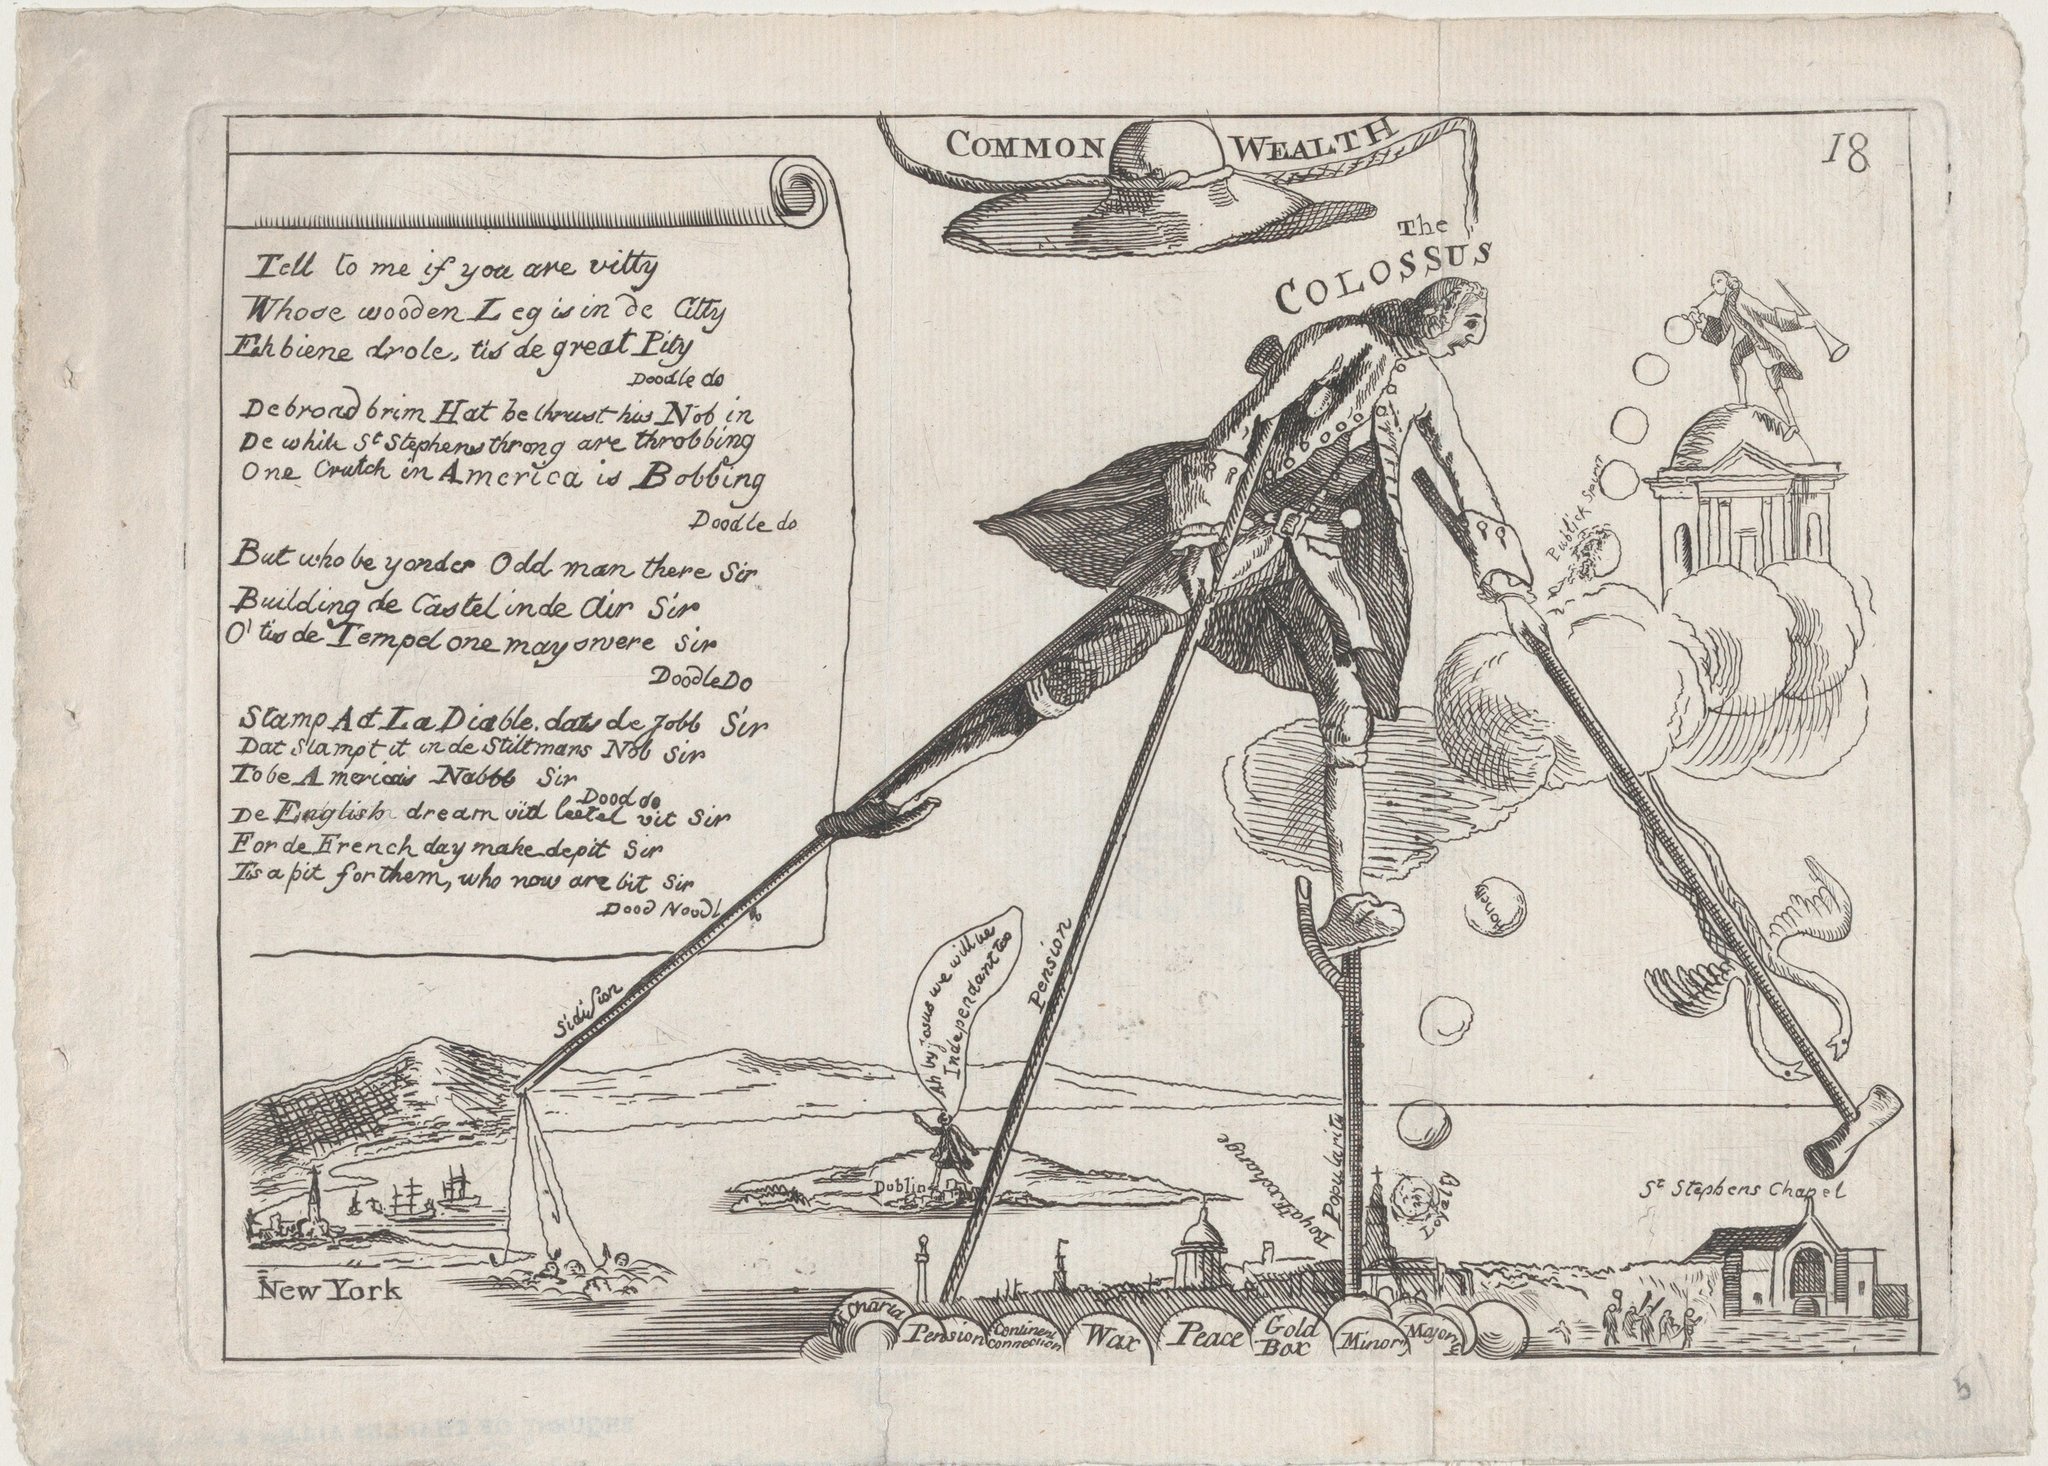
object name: print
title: Common-Wealth, The Colossus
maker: anonymous, british, 18th century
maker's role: artist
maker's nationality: british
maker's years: 1700-1800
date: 1766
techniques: etching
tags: satire,american revolution,men,politics